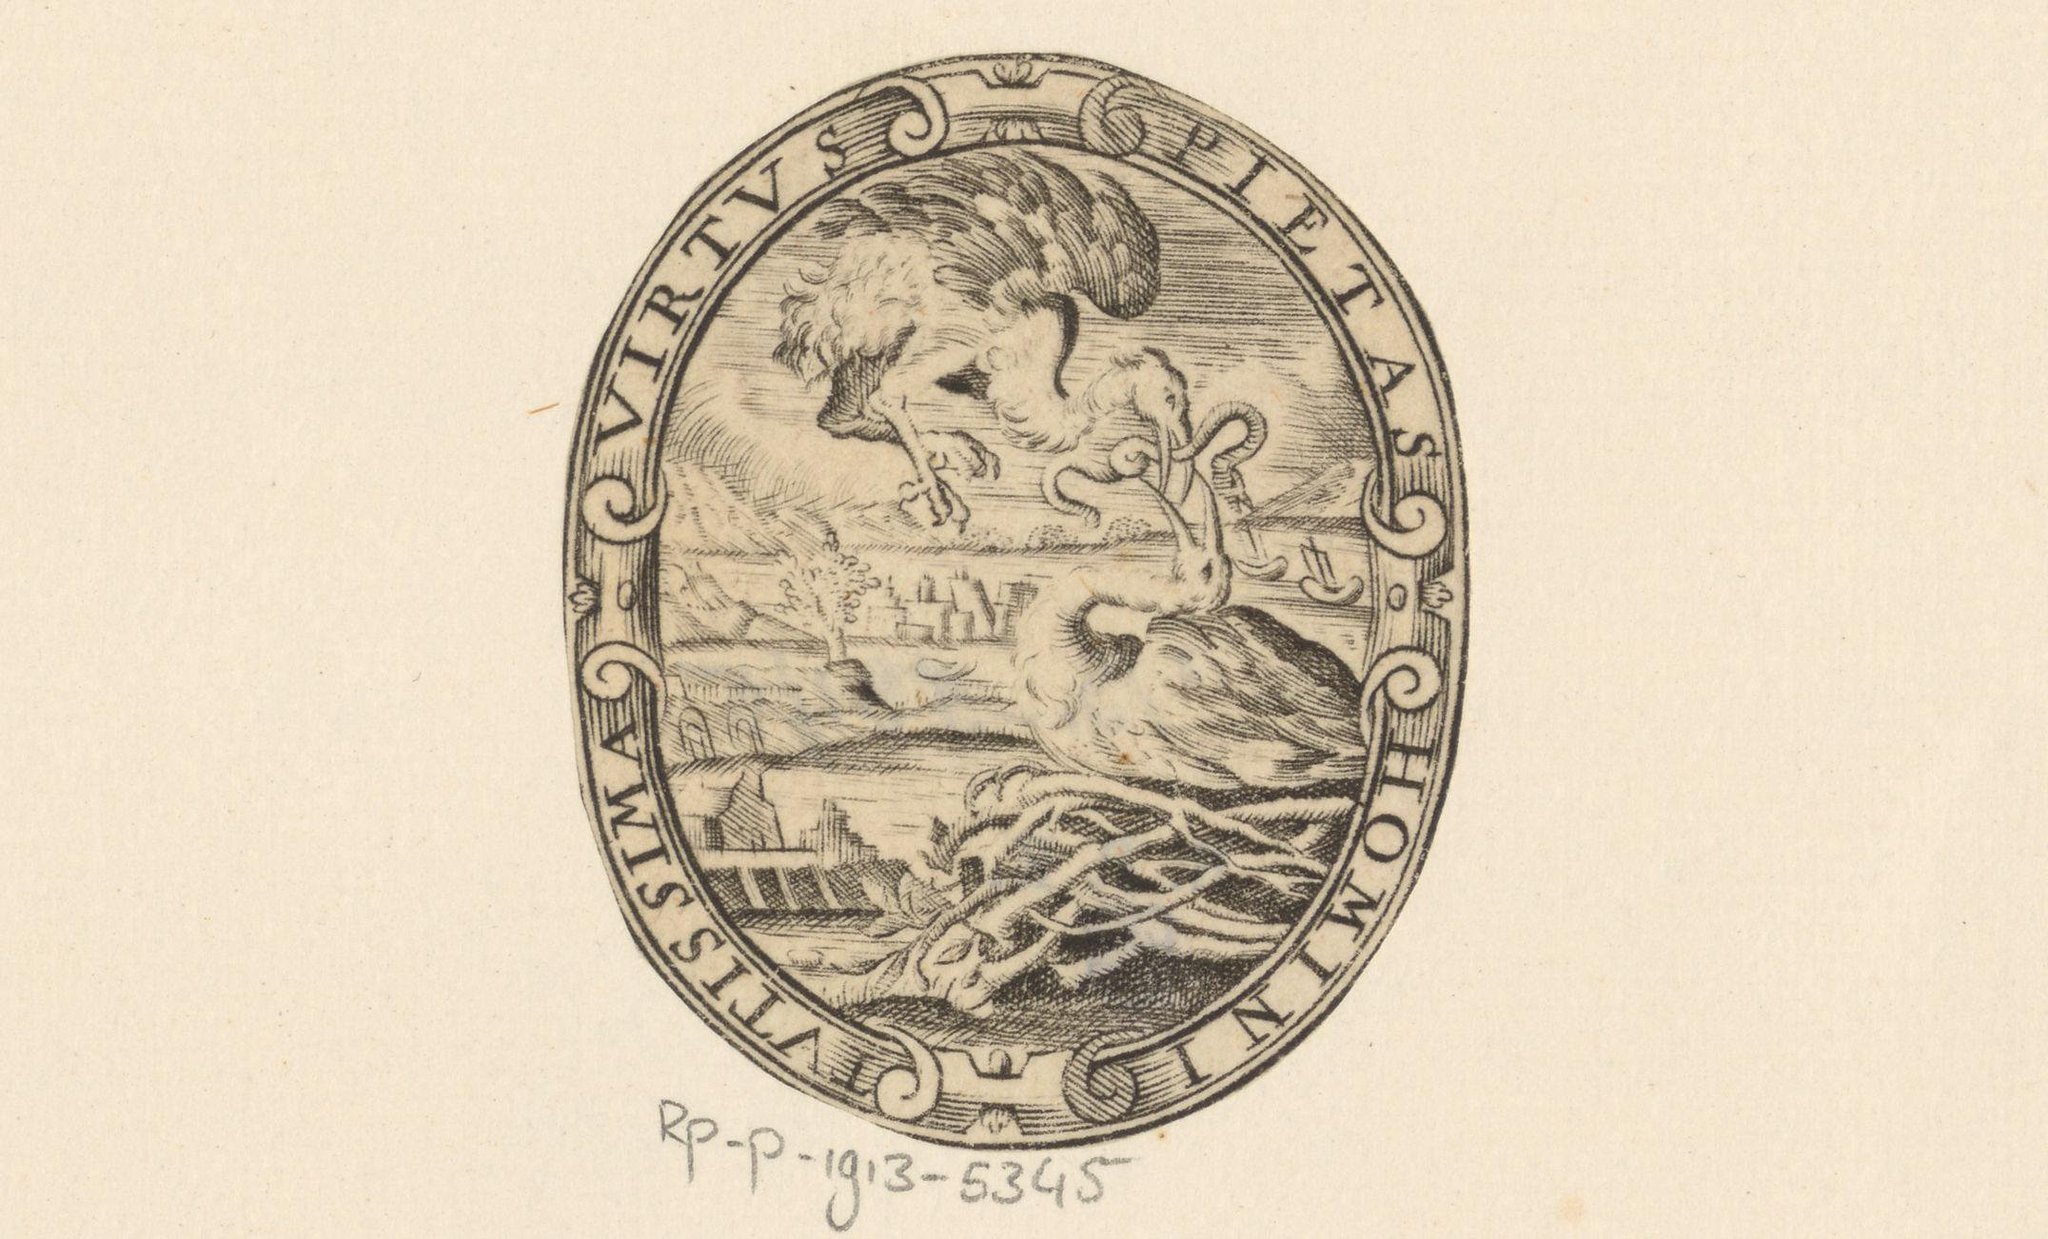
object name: bookplate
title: Pietas homini tutissima virtus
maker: Anonymous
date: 1669-1759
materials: paper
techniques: engraving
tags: birds, animals (+ feeding and care of young)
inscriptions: collector's mark: Lugt 2233, collector's mark: Lugt 2760